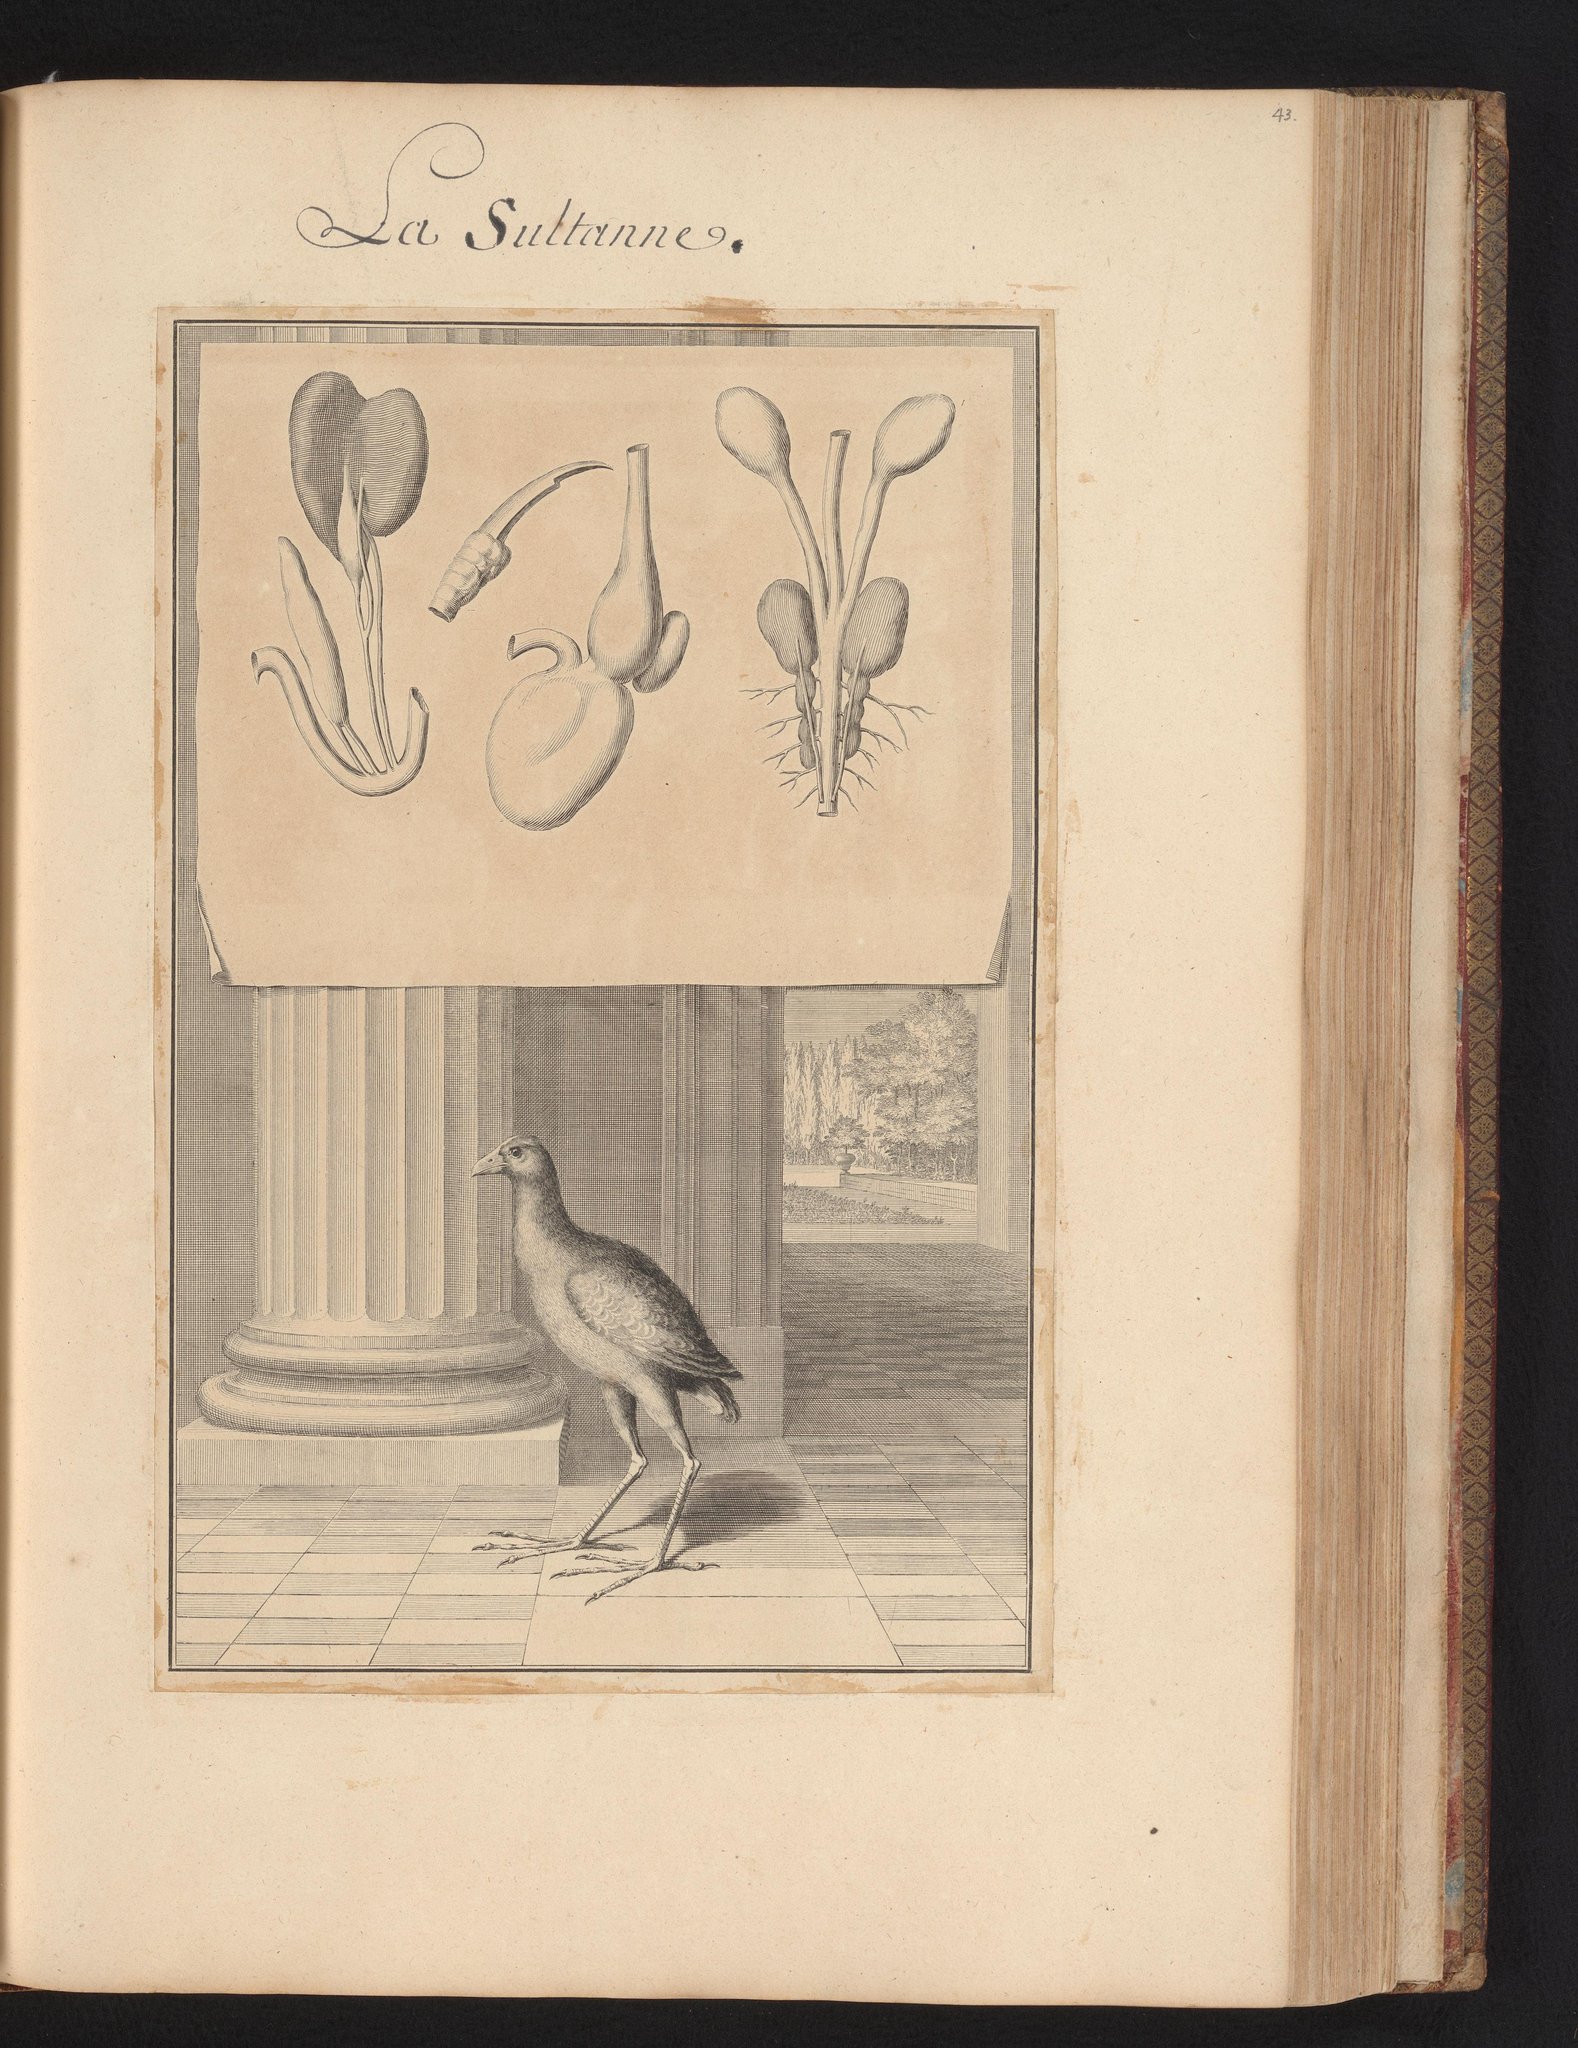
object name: album leaf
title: Purperkoet (porphyrio porphyrio) in een landschap met bovenaan op een blad de organen en botten van het dier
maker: sébastien leclerc (i)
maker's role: print maker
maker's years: 1637-1714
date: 1646-1714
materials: ink, paper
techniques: engraving, etching, pen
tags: dissection, water-birds: swamp-hen, animals (+ anatomy of animals)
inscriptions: inscription: ‘La Sultanne.’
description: Prent bedoeld voor een editie van Claude Perraults 'Mémoires pour servir à l'histoire naturelle des animaux'.